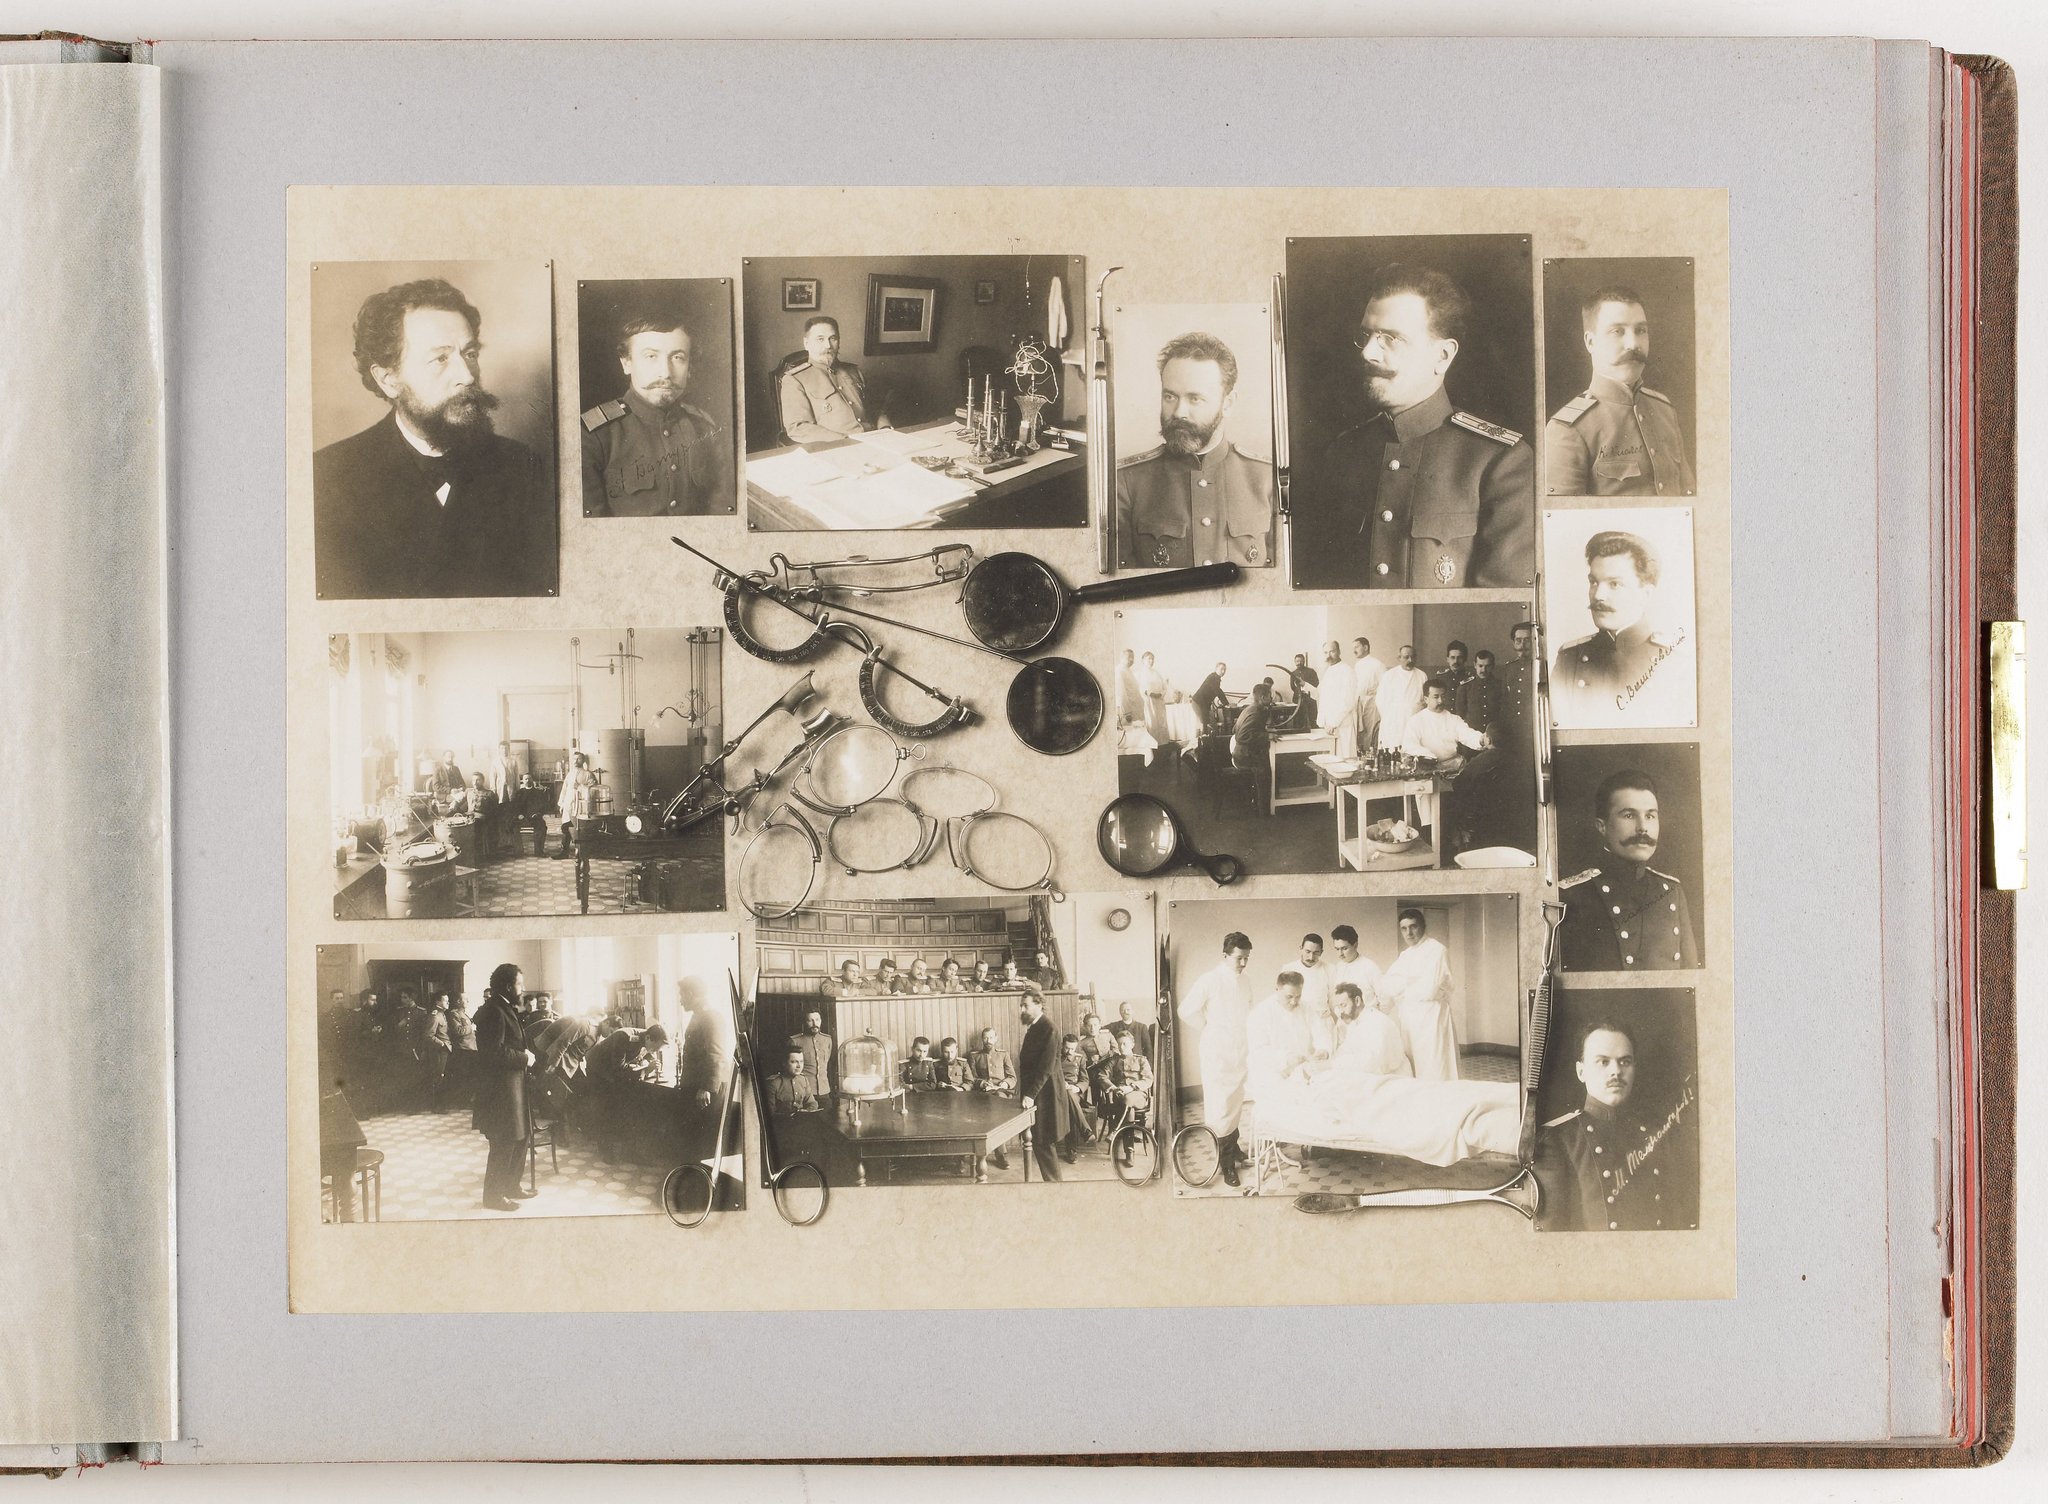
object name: album leaf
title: Compositie van veertien foto's van personen en onderwijs aan de Keizerlijke Militair-Medische Academie, gecombineerd met decoratie van brillen en medische instrumenten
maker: v. sabelskij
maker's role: fotograaf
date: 1913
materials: cardboard, paper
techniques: salted paper print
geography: sint-petersburg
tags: eyeglasses, spectacles, military academy, medicine, medical science, historical persons not known by name